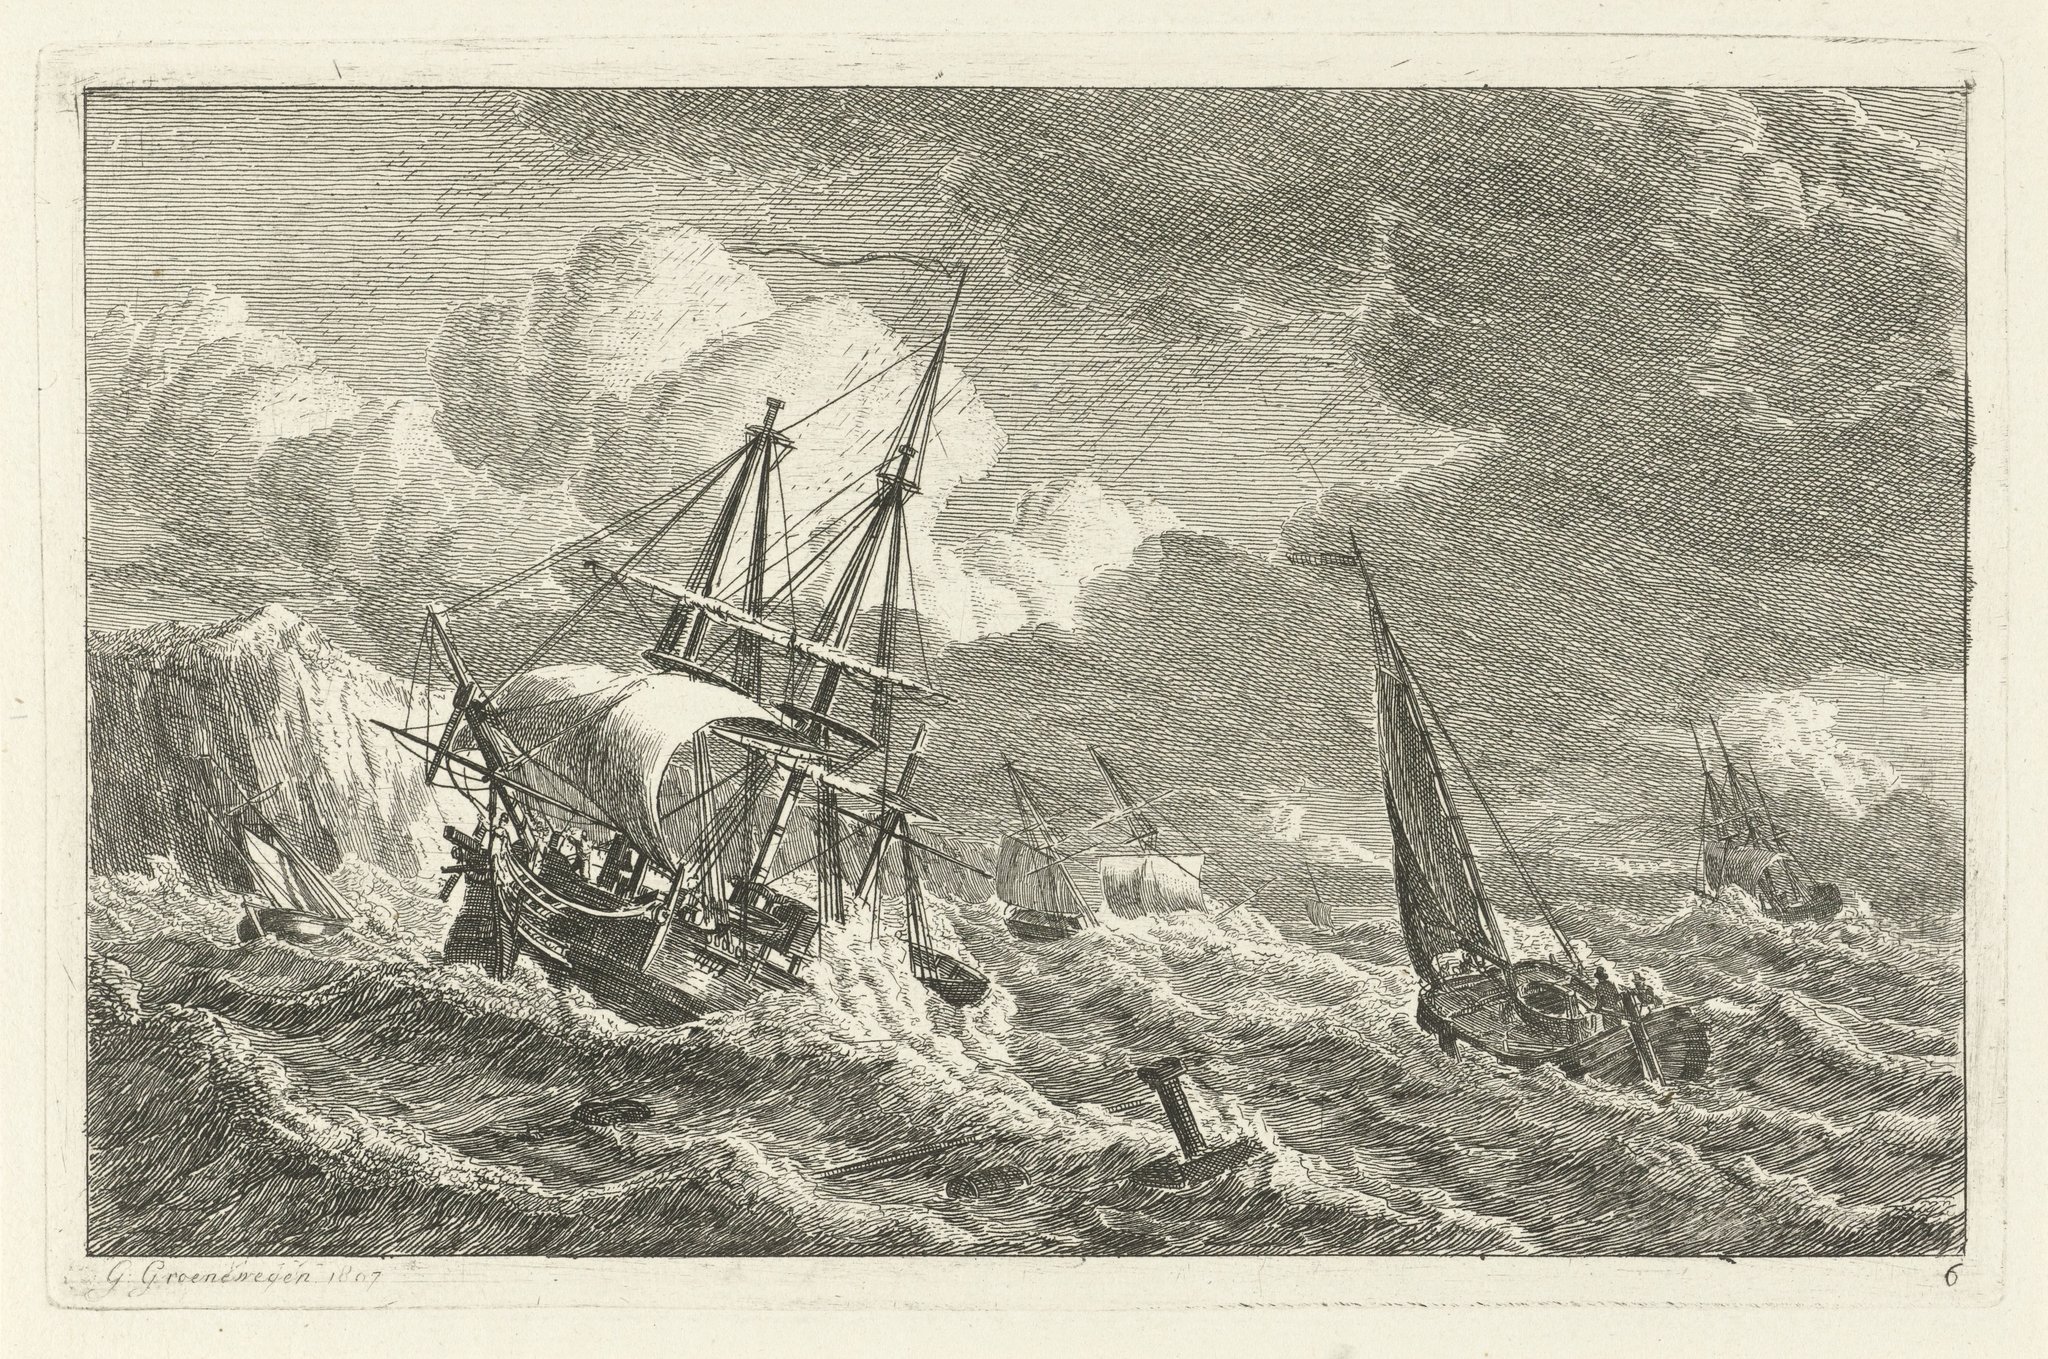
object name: print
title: Schepen in nood bij een rotsachtige kust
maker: gerrit groenewegen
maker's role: draughtsman, print maker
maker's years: 1754-1826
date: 1807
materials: paper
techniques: etching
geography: rotterdam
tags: ships (in general) - cc - more than one ship, storm at sea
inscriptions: collector's mark: Lugt 2228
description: Storm op zee. Links een driemaster die op het punt staat om tegen de rotsen te slaan. Rechts een visschersschuit, waarin twee personen aan het roer staan. Deze prent maakt deel uit van een serie van zes prenten met diverse schepen.